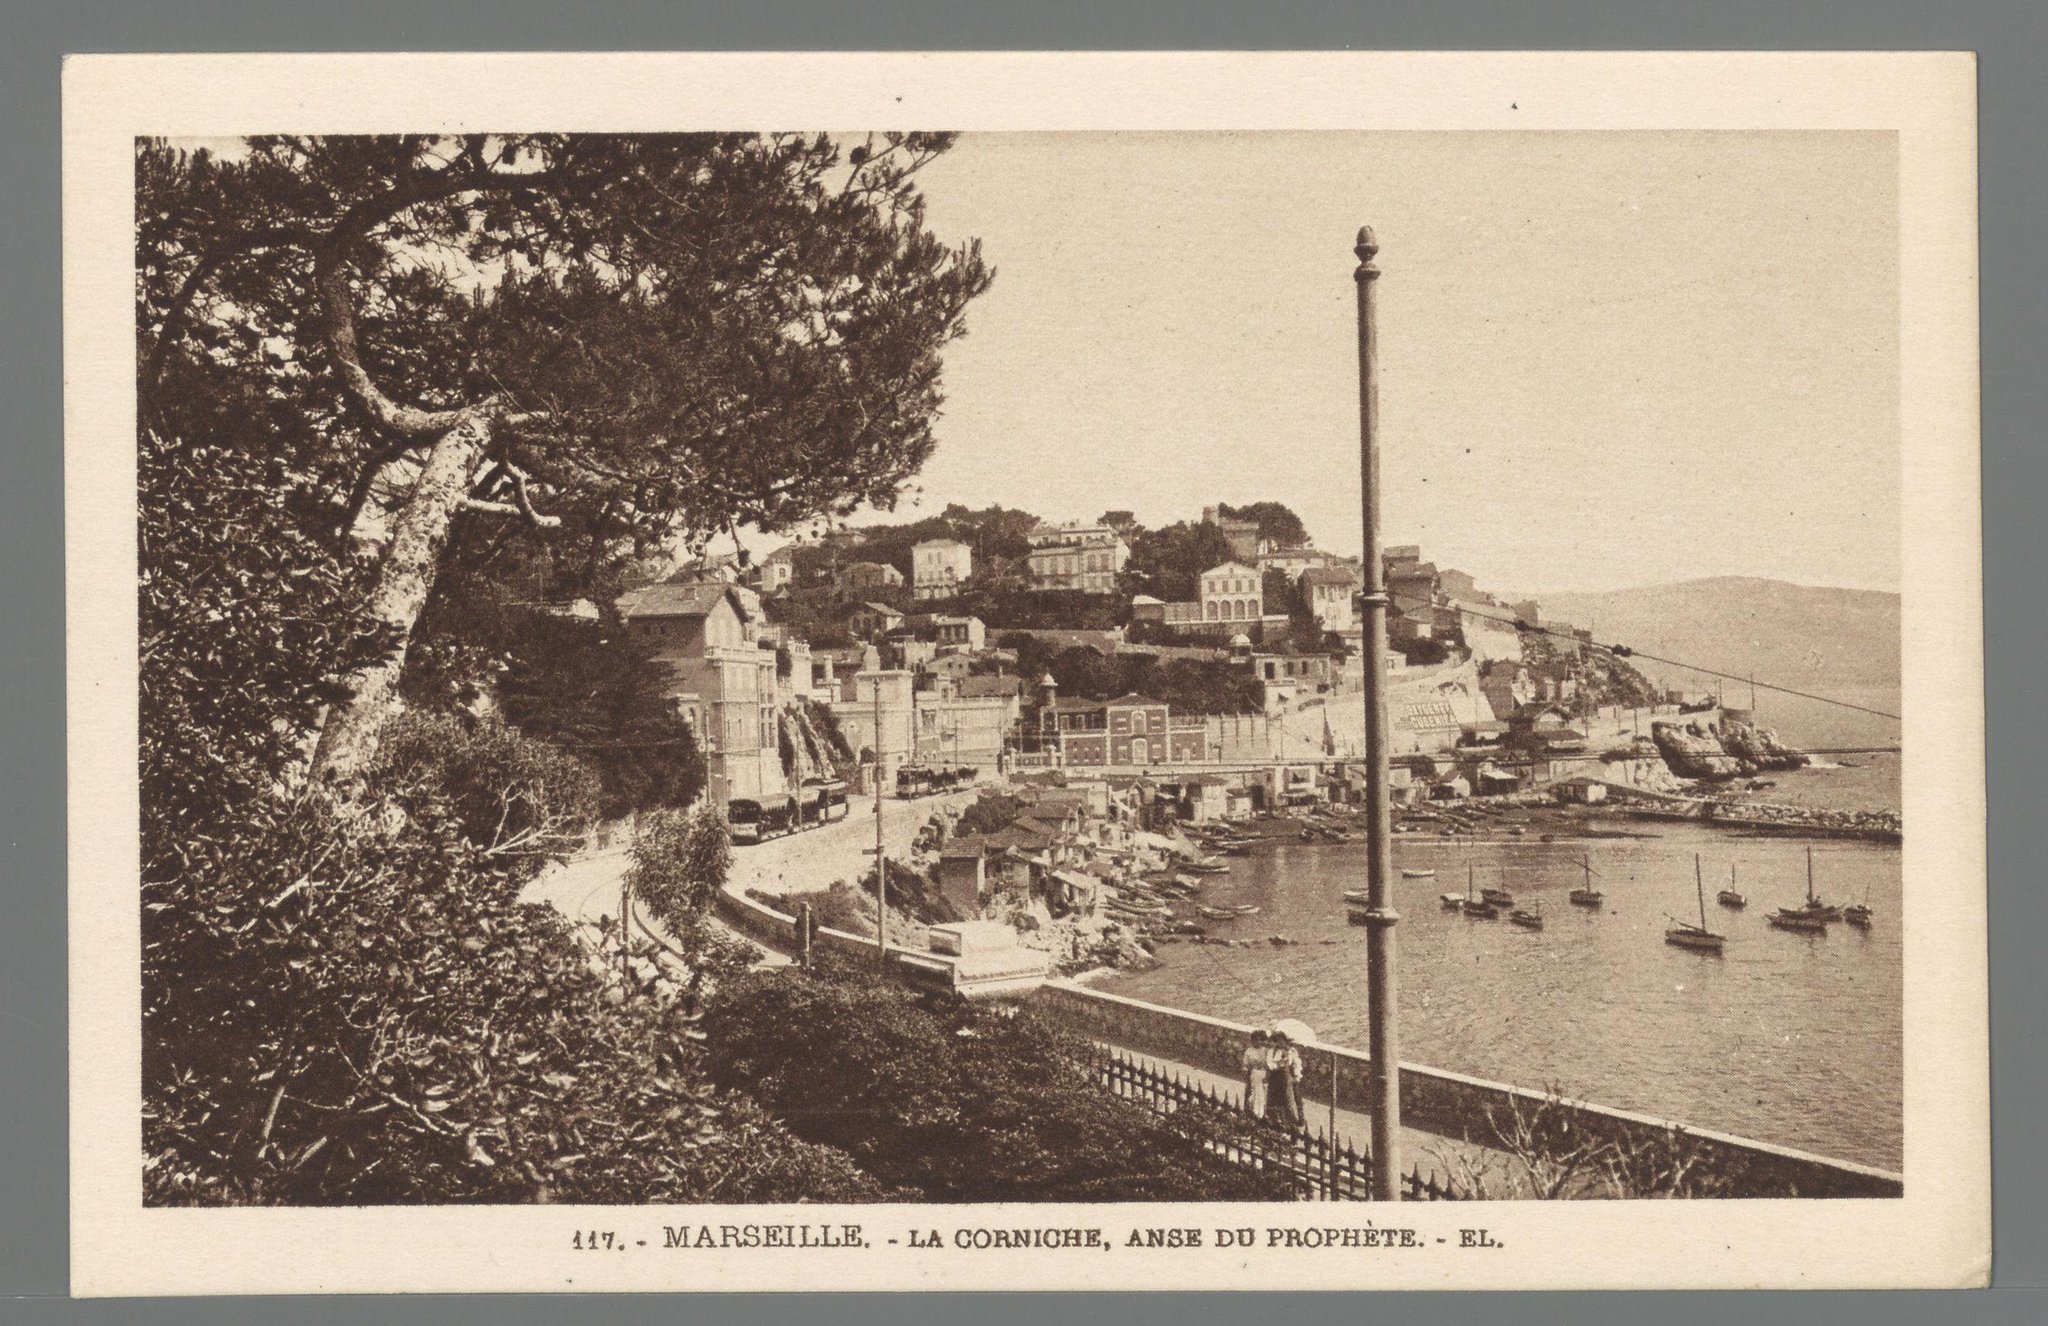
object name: photomechanical print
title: Marseille. La Corniche, Anse du Prophète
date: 1903-1913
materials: cardboard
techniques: rotogravure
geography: marseille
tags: tramway, tram, sea (seascape), marseille